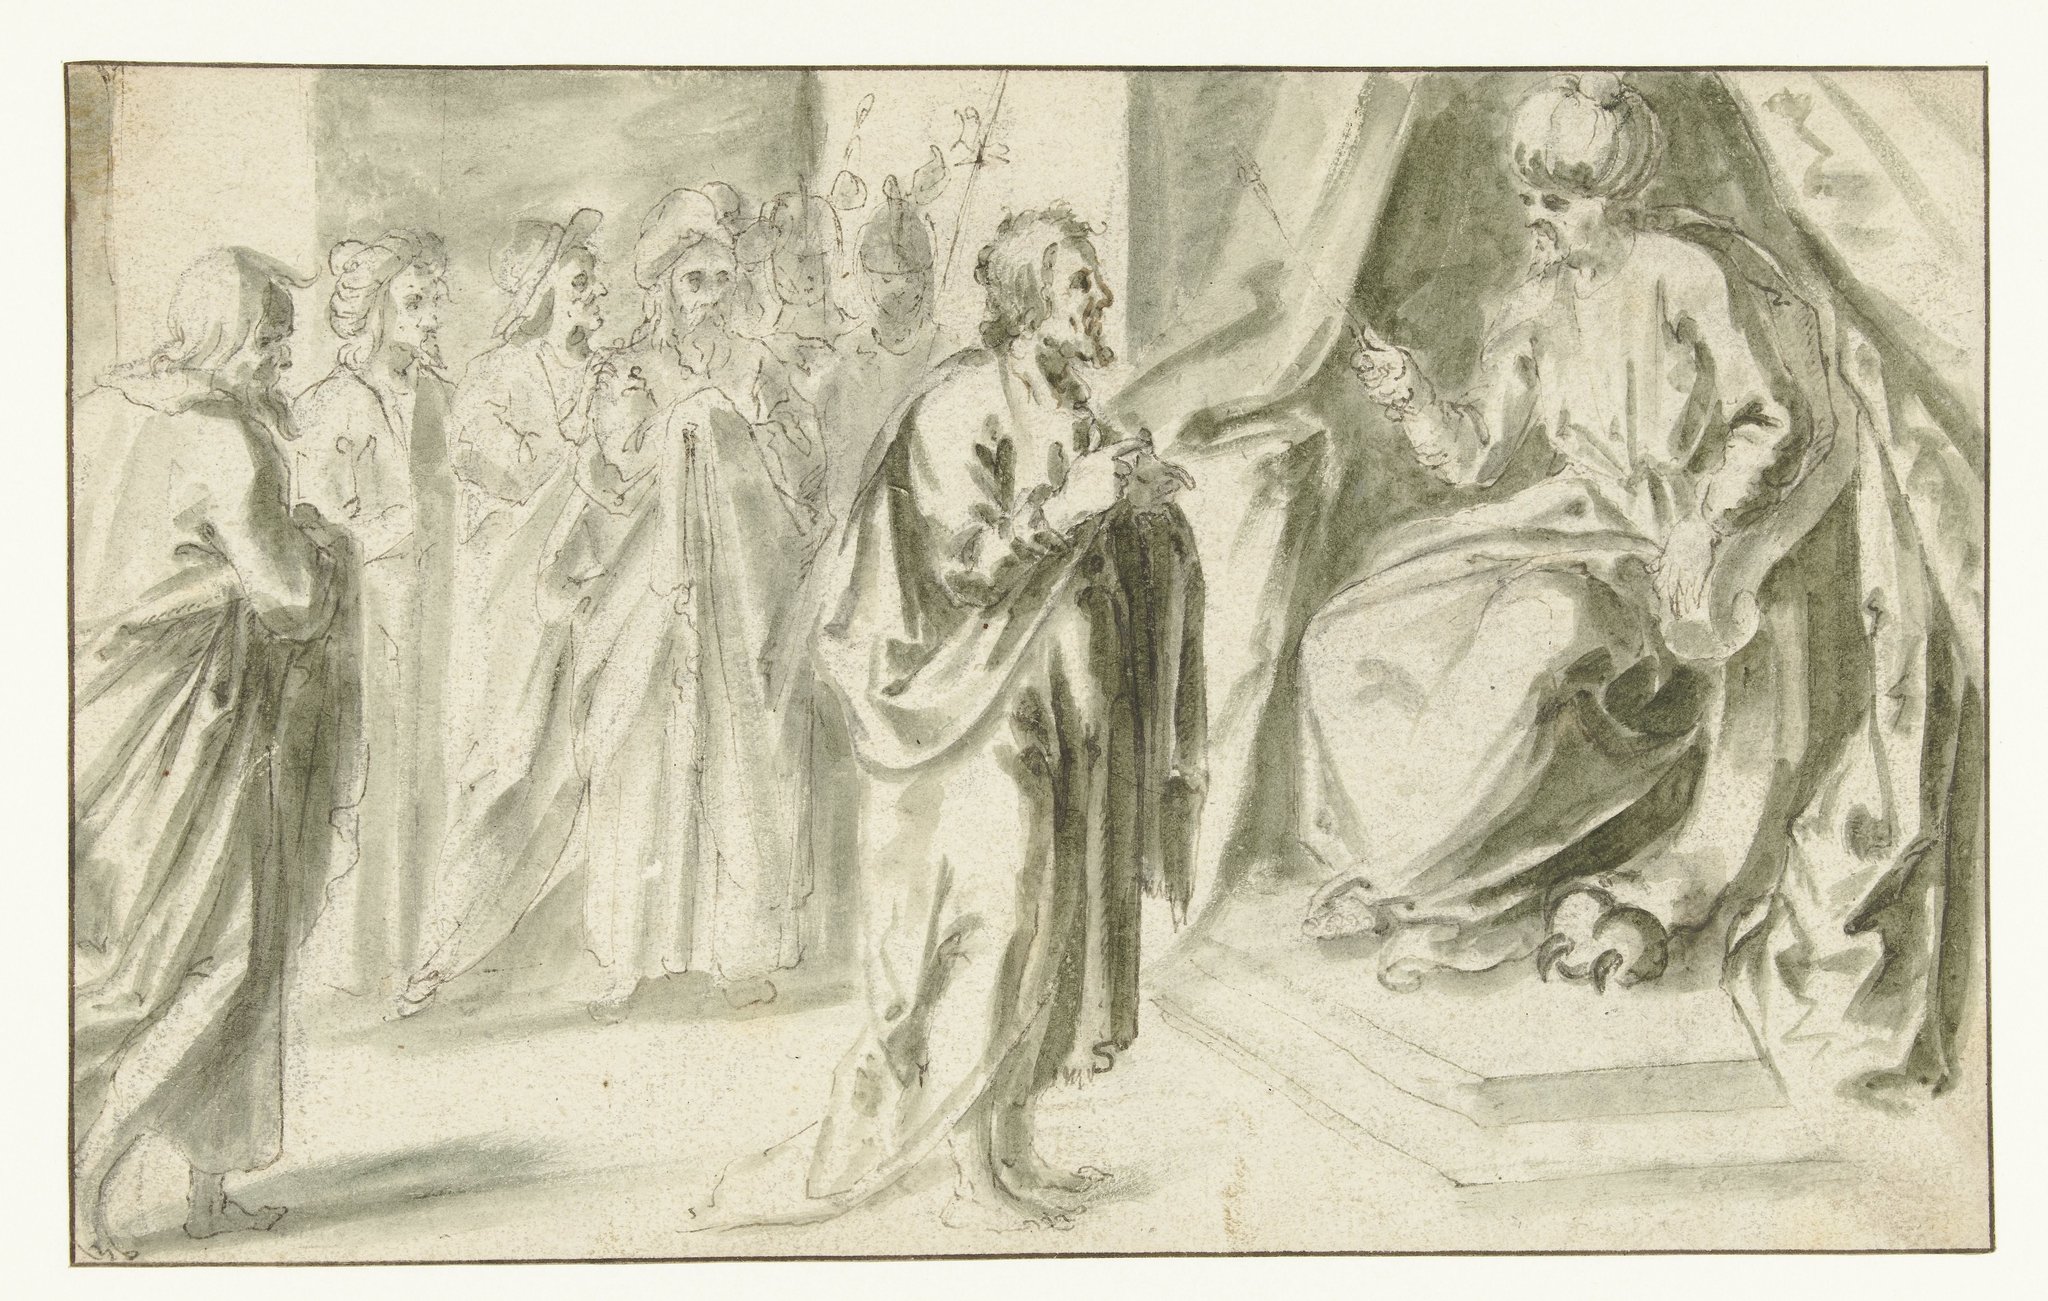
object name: drawing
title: Oude Testament onderwerpen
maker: karel van mander (i)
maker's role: draughtsman, painter, print maker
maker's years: 1548-1606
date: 1558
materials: ink, paper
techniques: brush, pen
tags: pharaoh's dreams ~ story of joseph